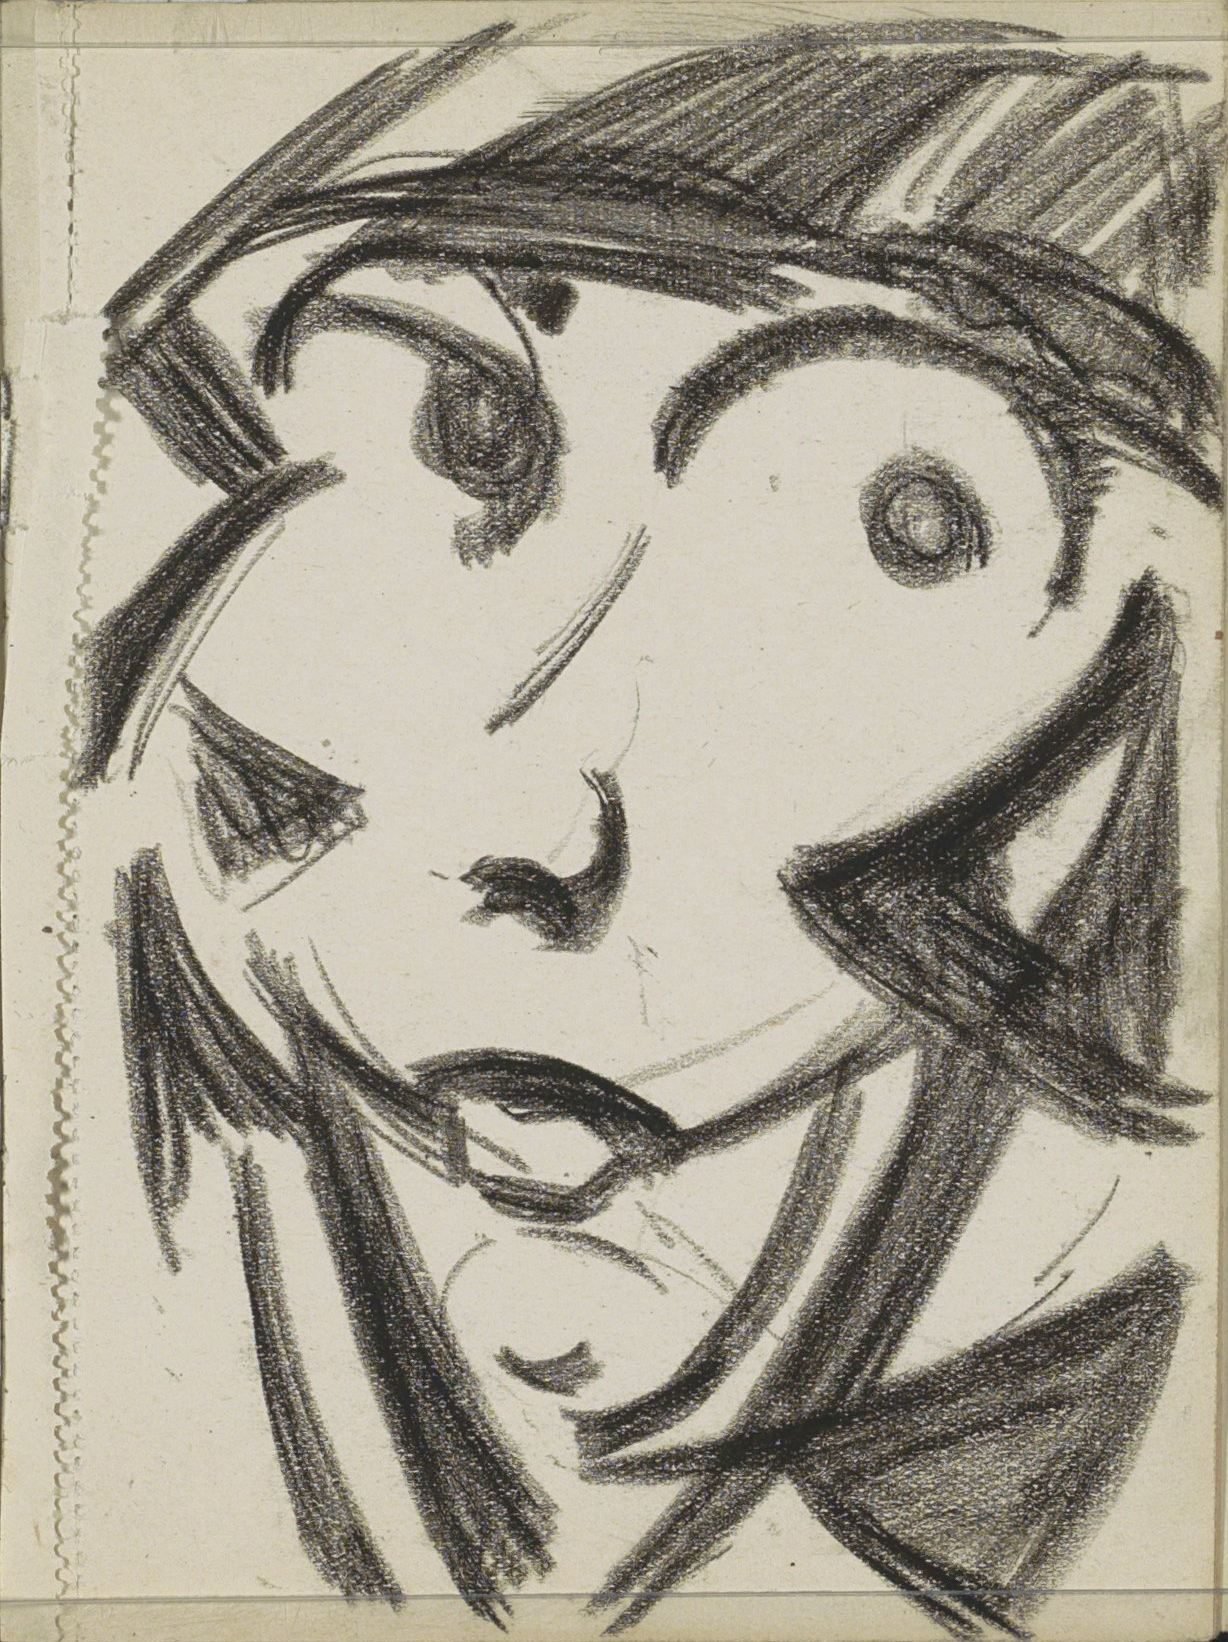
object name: sketchbook leaf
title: Kop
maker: reijer stolk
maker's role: draughtsman, print maker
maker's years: 1896-1945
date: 1906-1945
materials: chalk, paper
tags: head (human)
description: Blad 6 recto uit een schetsboek met 53 bladen.